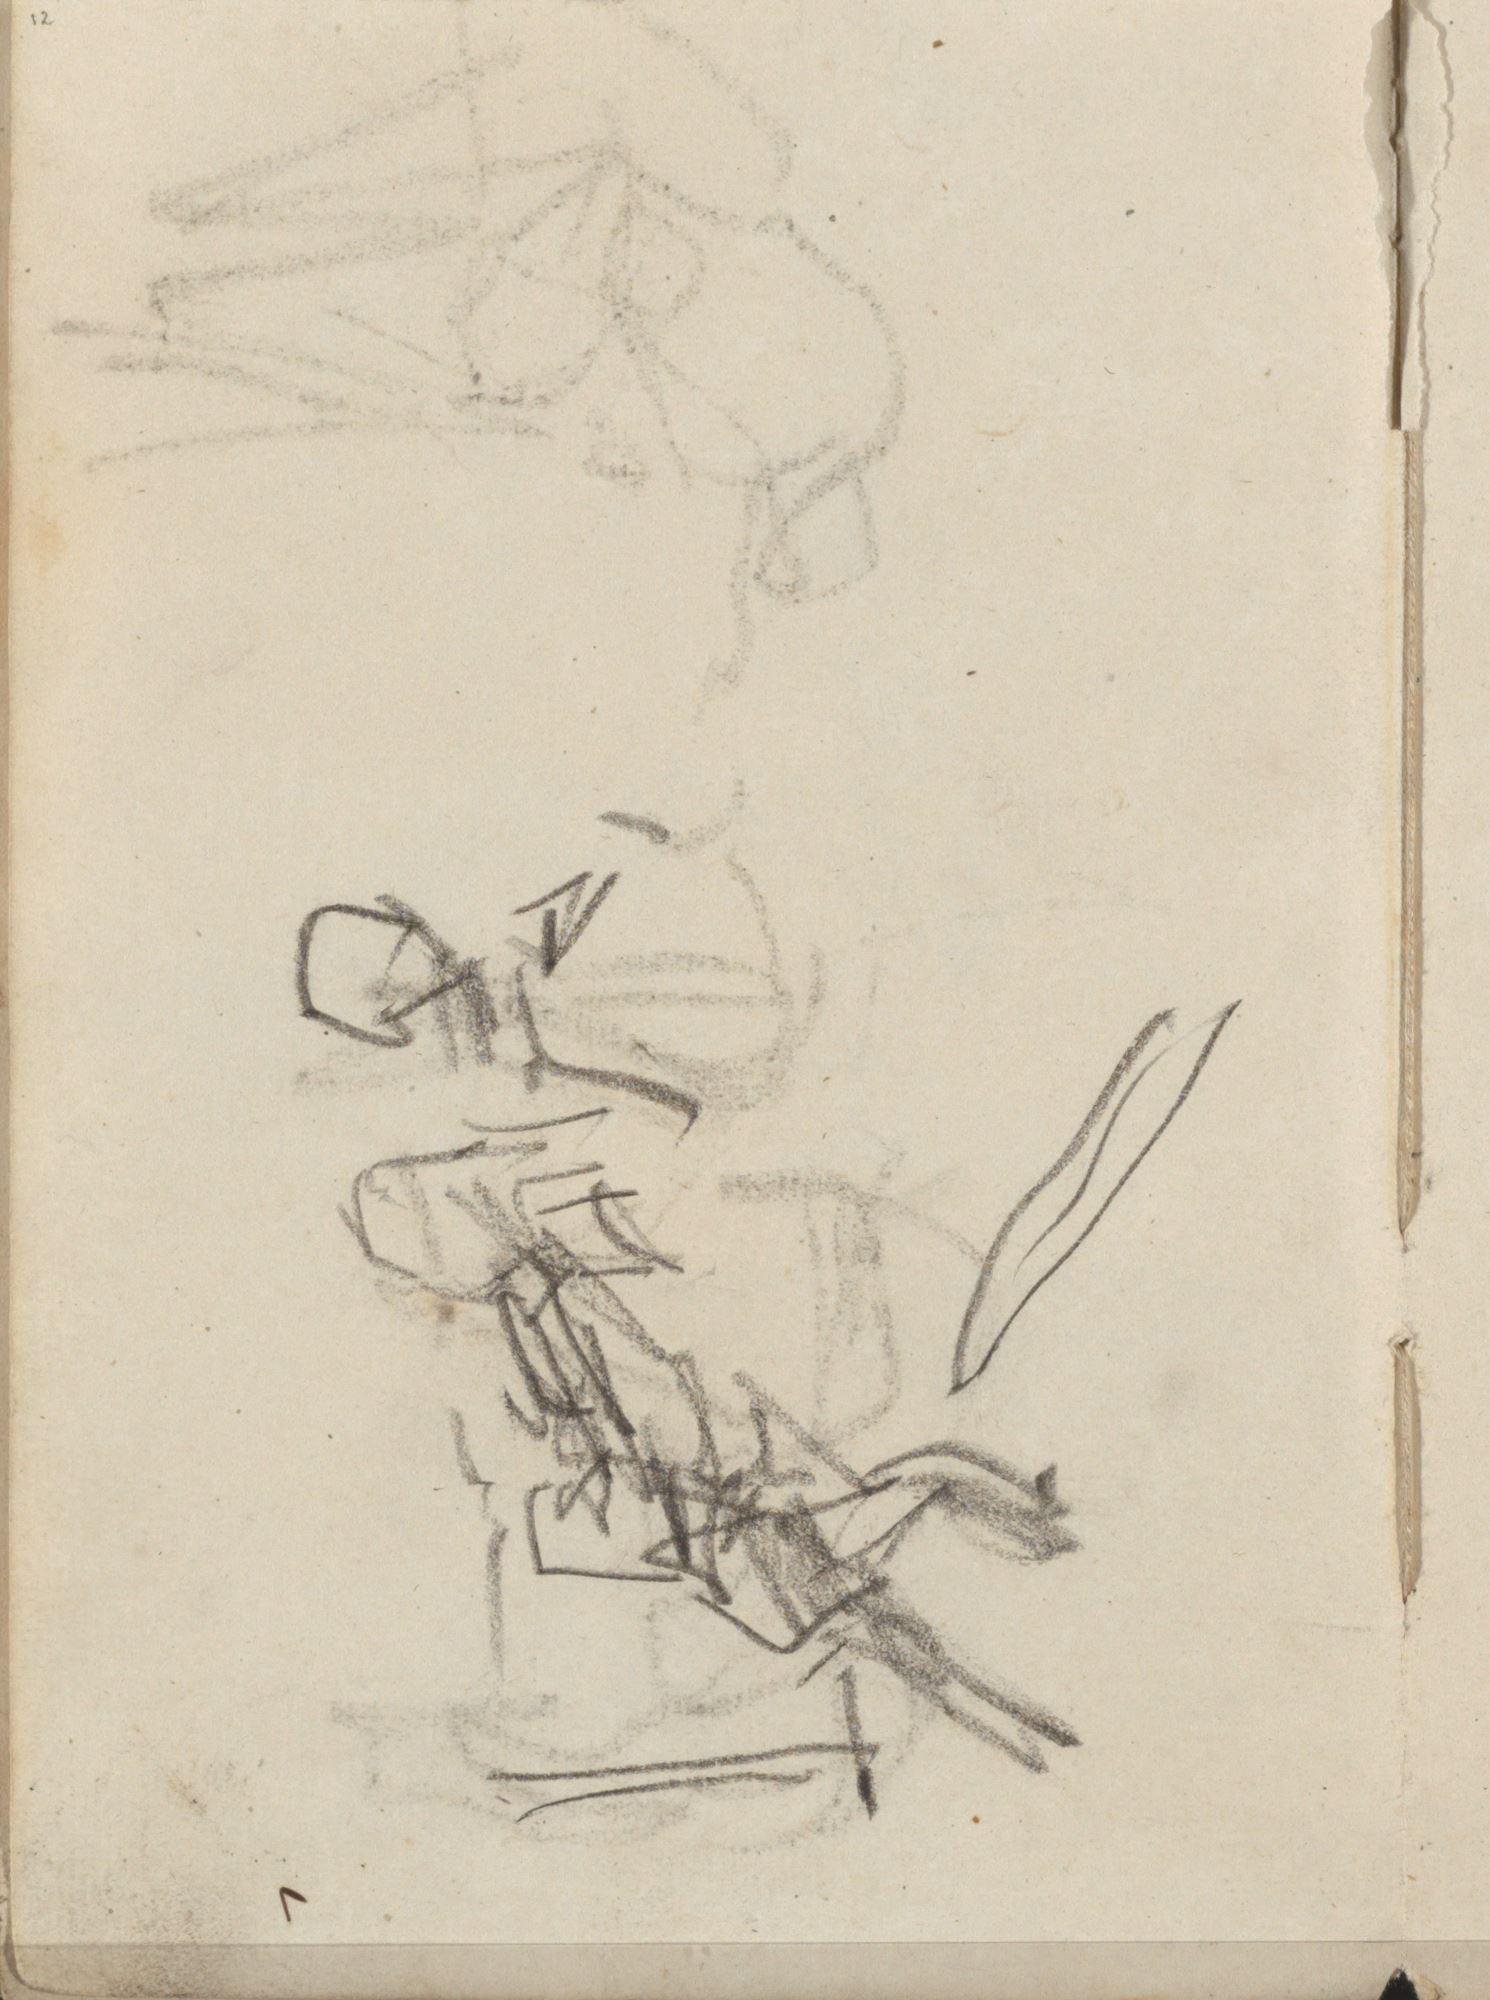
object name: sketchbook leaf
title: Figuurstudies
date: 1881-1883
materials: chalk, paper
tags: adult woman, adult man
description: Pagina 12 uit een schetsboek met 29 bladen.